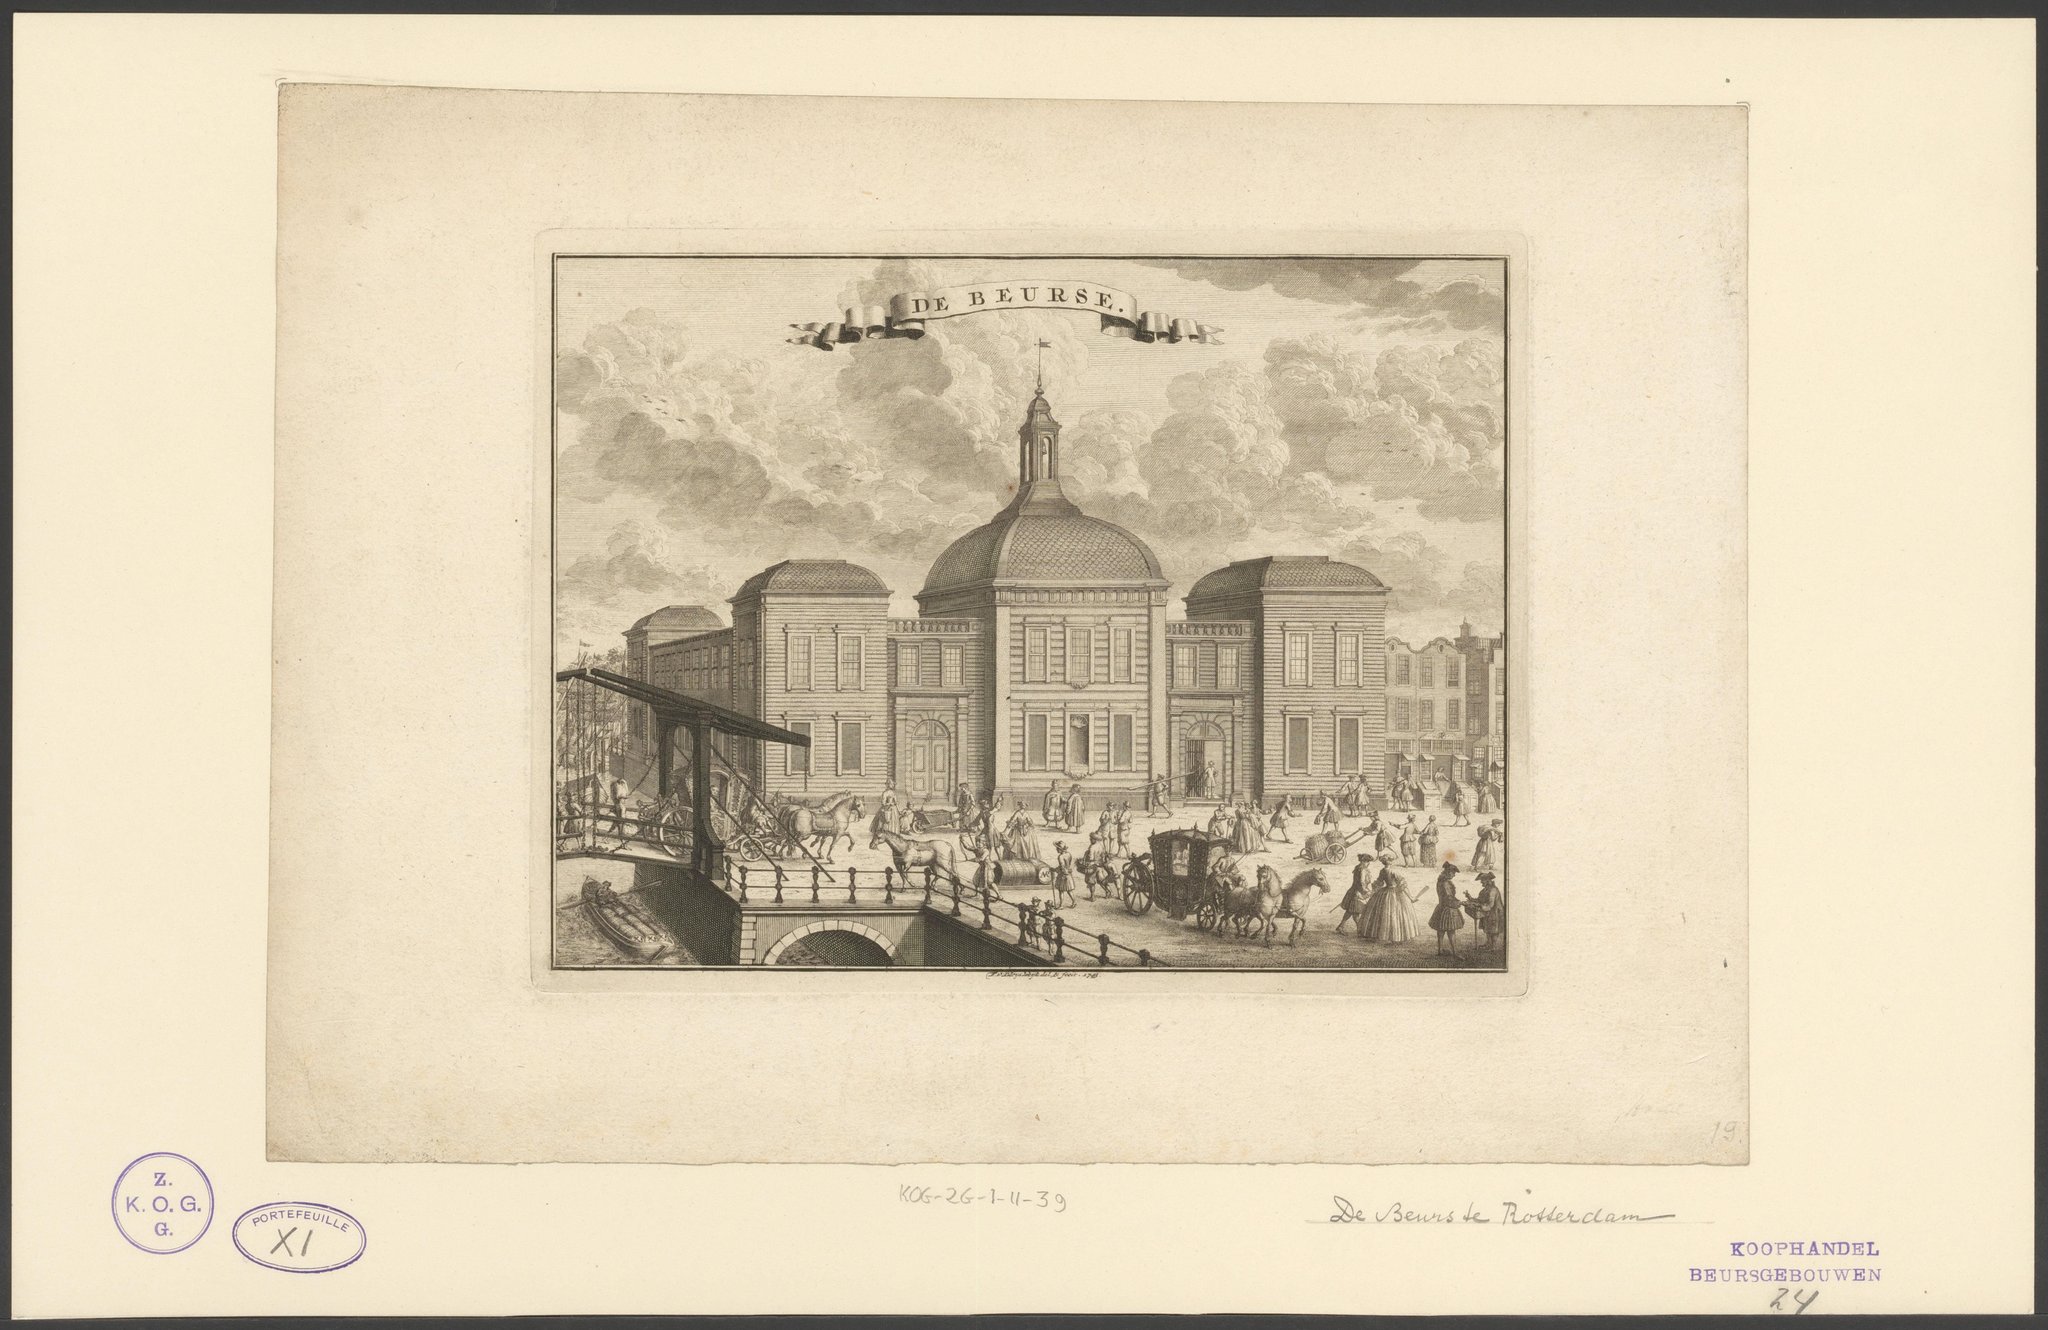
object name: print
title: De Beurse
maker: françois van bleyswijck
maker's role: draughtsman, print maker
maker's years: 1671-1746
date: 1743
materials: paper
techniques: etching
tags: canal, stock exchange, stock-market, four-wheeled vehicle drawn by two animals, street (+ city(-scape) with figures, staffage)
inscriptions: stamp, stamp, collector's mark: Lugt 1641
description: Gezicht op het in 1736 voltooide beursgebouw aan de Blaak te Rotterdam. Onderwerpsrubrieken binnen de Atlas Zeden en Gewoonten: Handel, nijverheid en verkeer, Koophandel, Beursgebouwen.